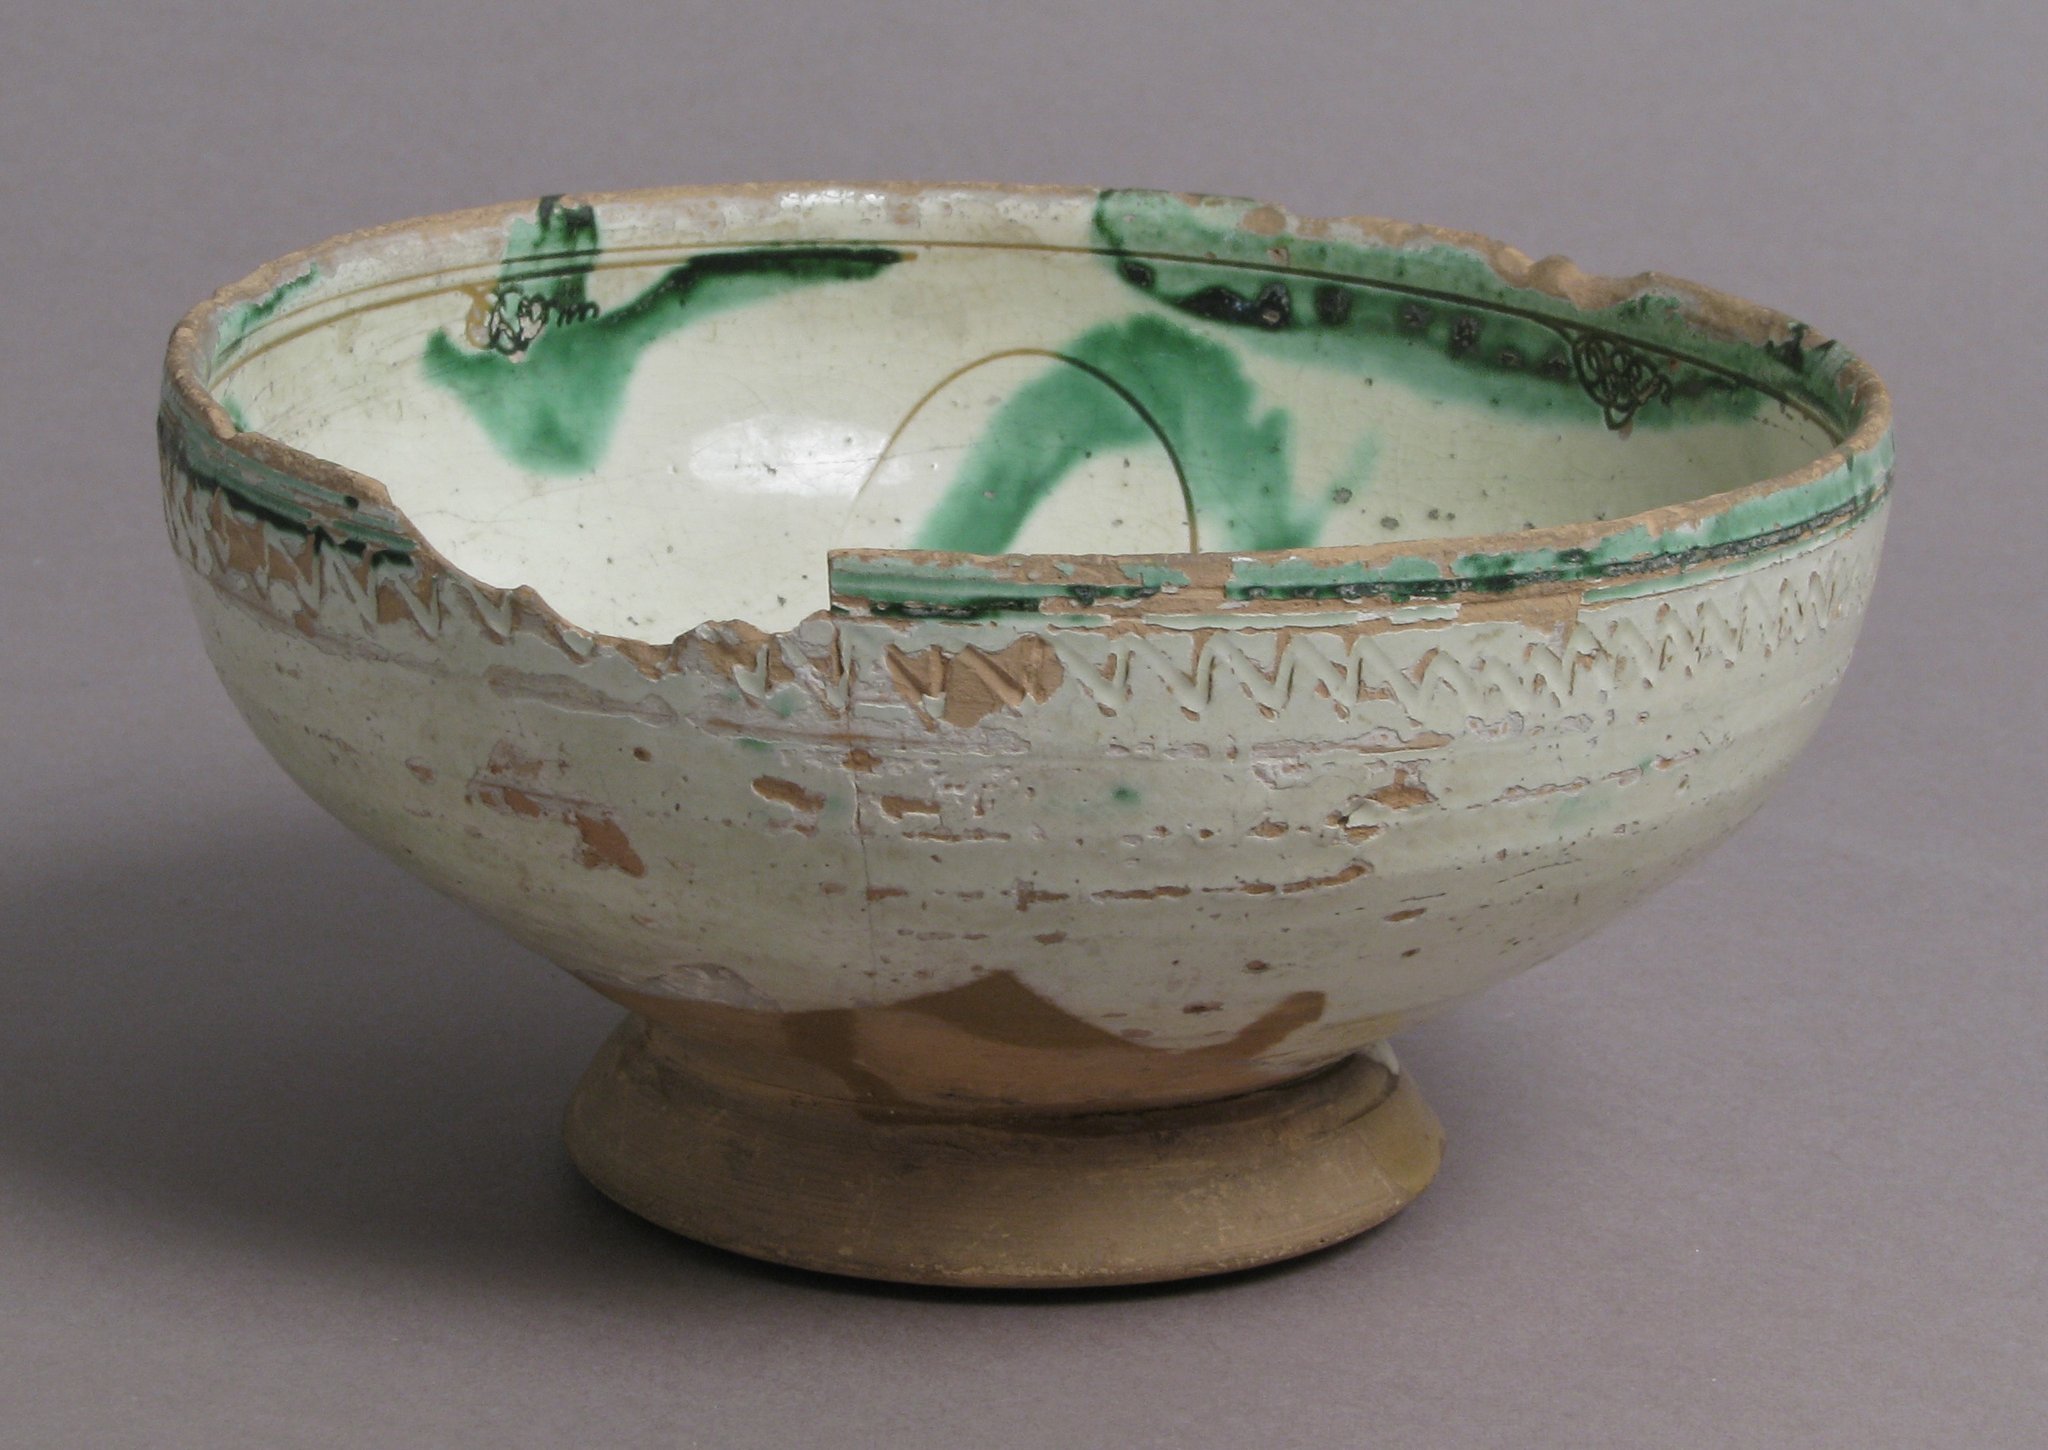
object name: bowl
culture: byzantine or italian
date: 1001-1200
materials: earthenware, glaze